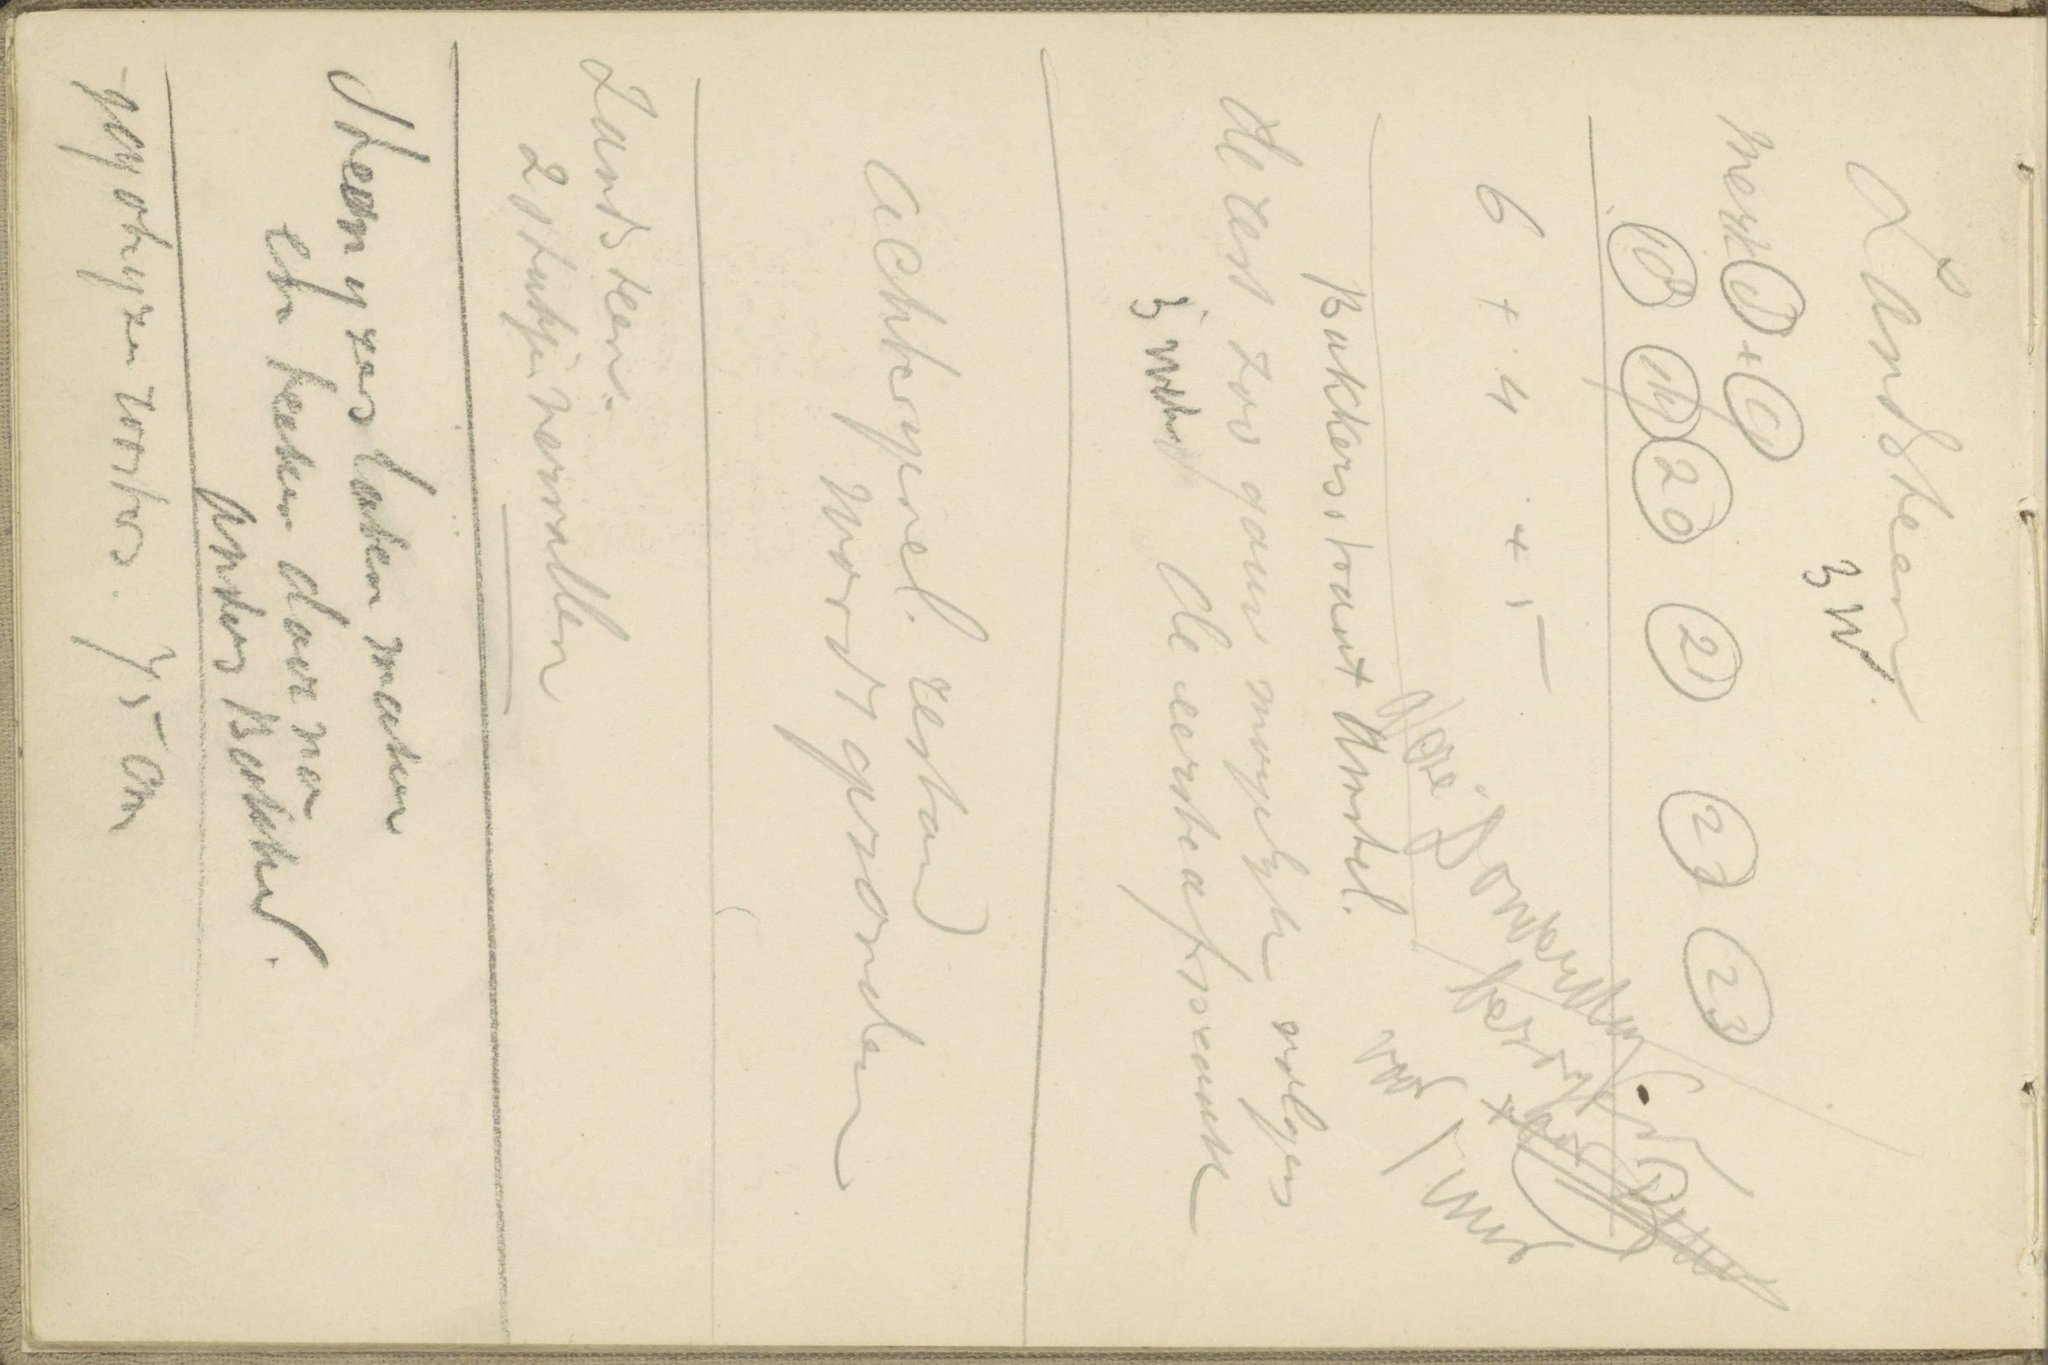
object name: sketchbook leaf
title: Notities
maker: carel adolph lion cachet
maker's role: draughtsman, print maker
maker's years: 1864-1945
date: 1905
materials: paper, pencil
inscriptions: annotation: ‘Zandsteen [...] bakken’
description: Blad 3 verso uit een schetsboek met 27 bladen.